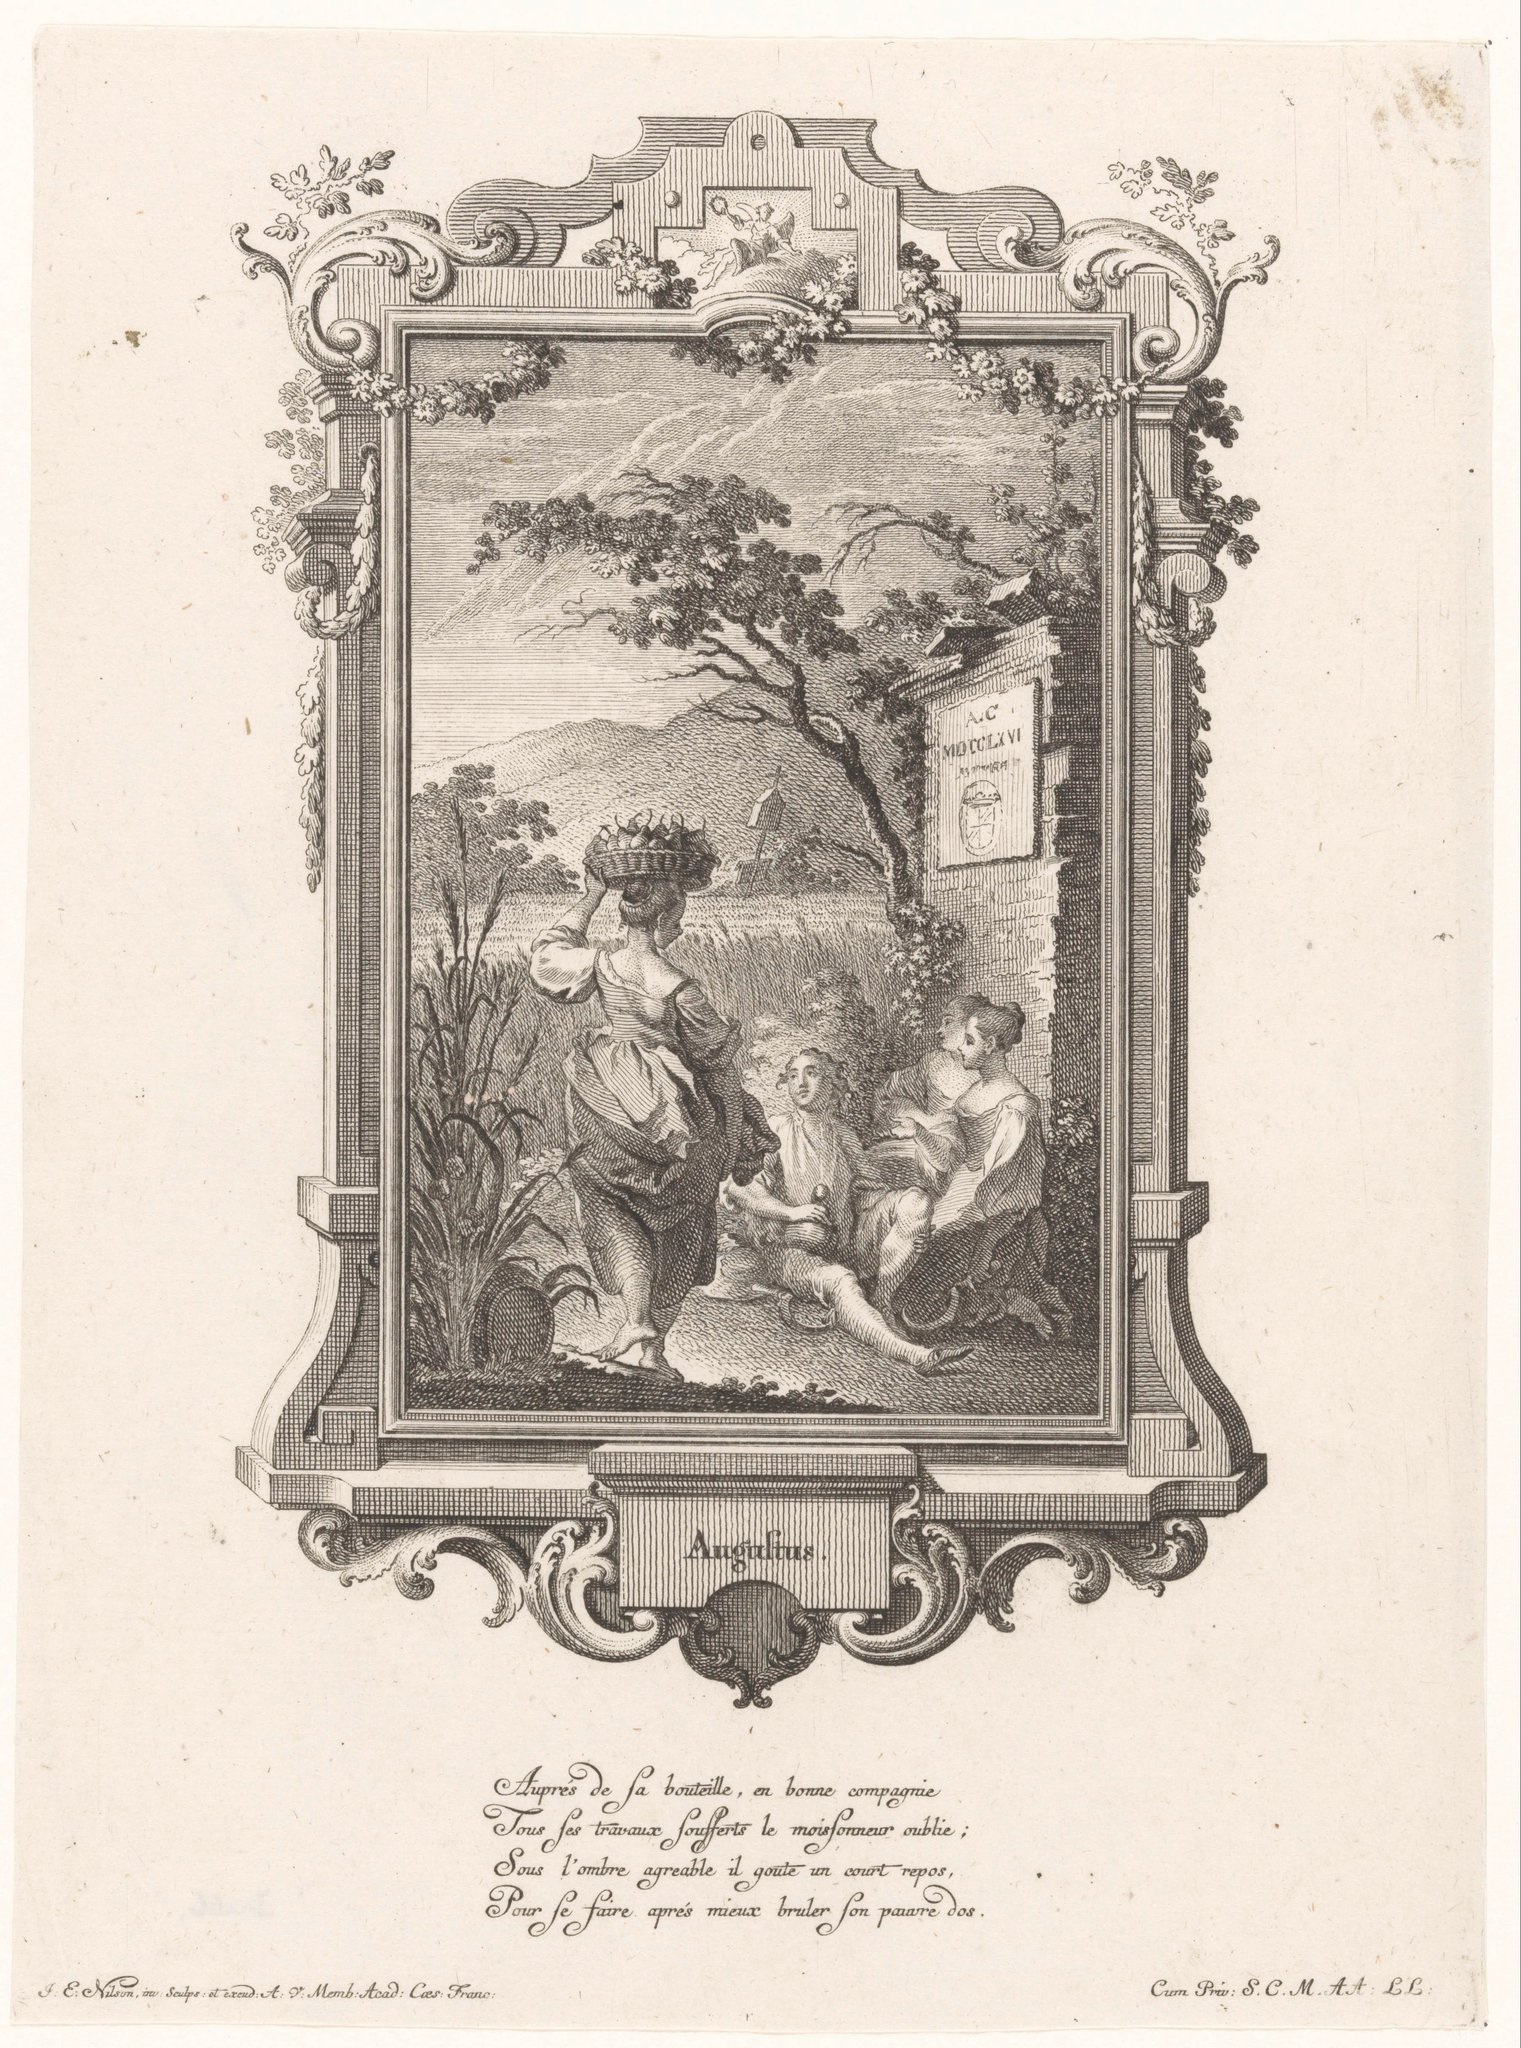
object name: ornament print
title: Augustus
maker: johann esaias nilson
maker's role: draughtsman, print maker, publisher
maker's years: 1721-1788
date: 1766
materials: paper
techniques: engraving, etching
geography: augsburg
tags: august and its 'labours', rest during harvest (eating, dancing, making love, etc.)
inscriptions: collector's mark: Lugt 2228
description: In een rocaille omlijsting met guirlandes een voorstelling met rustende mensen. In een landschap zitten een man en twee vrouwen met hun sikkels en een fles drinken. Een vrouw met een mand met peren op het hoofd loopt langs. In de ondermarge een vierregelige Franse tekst.